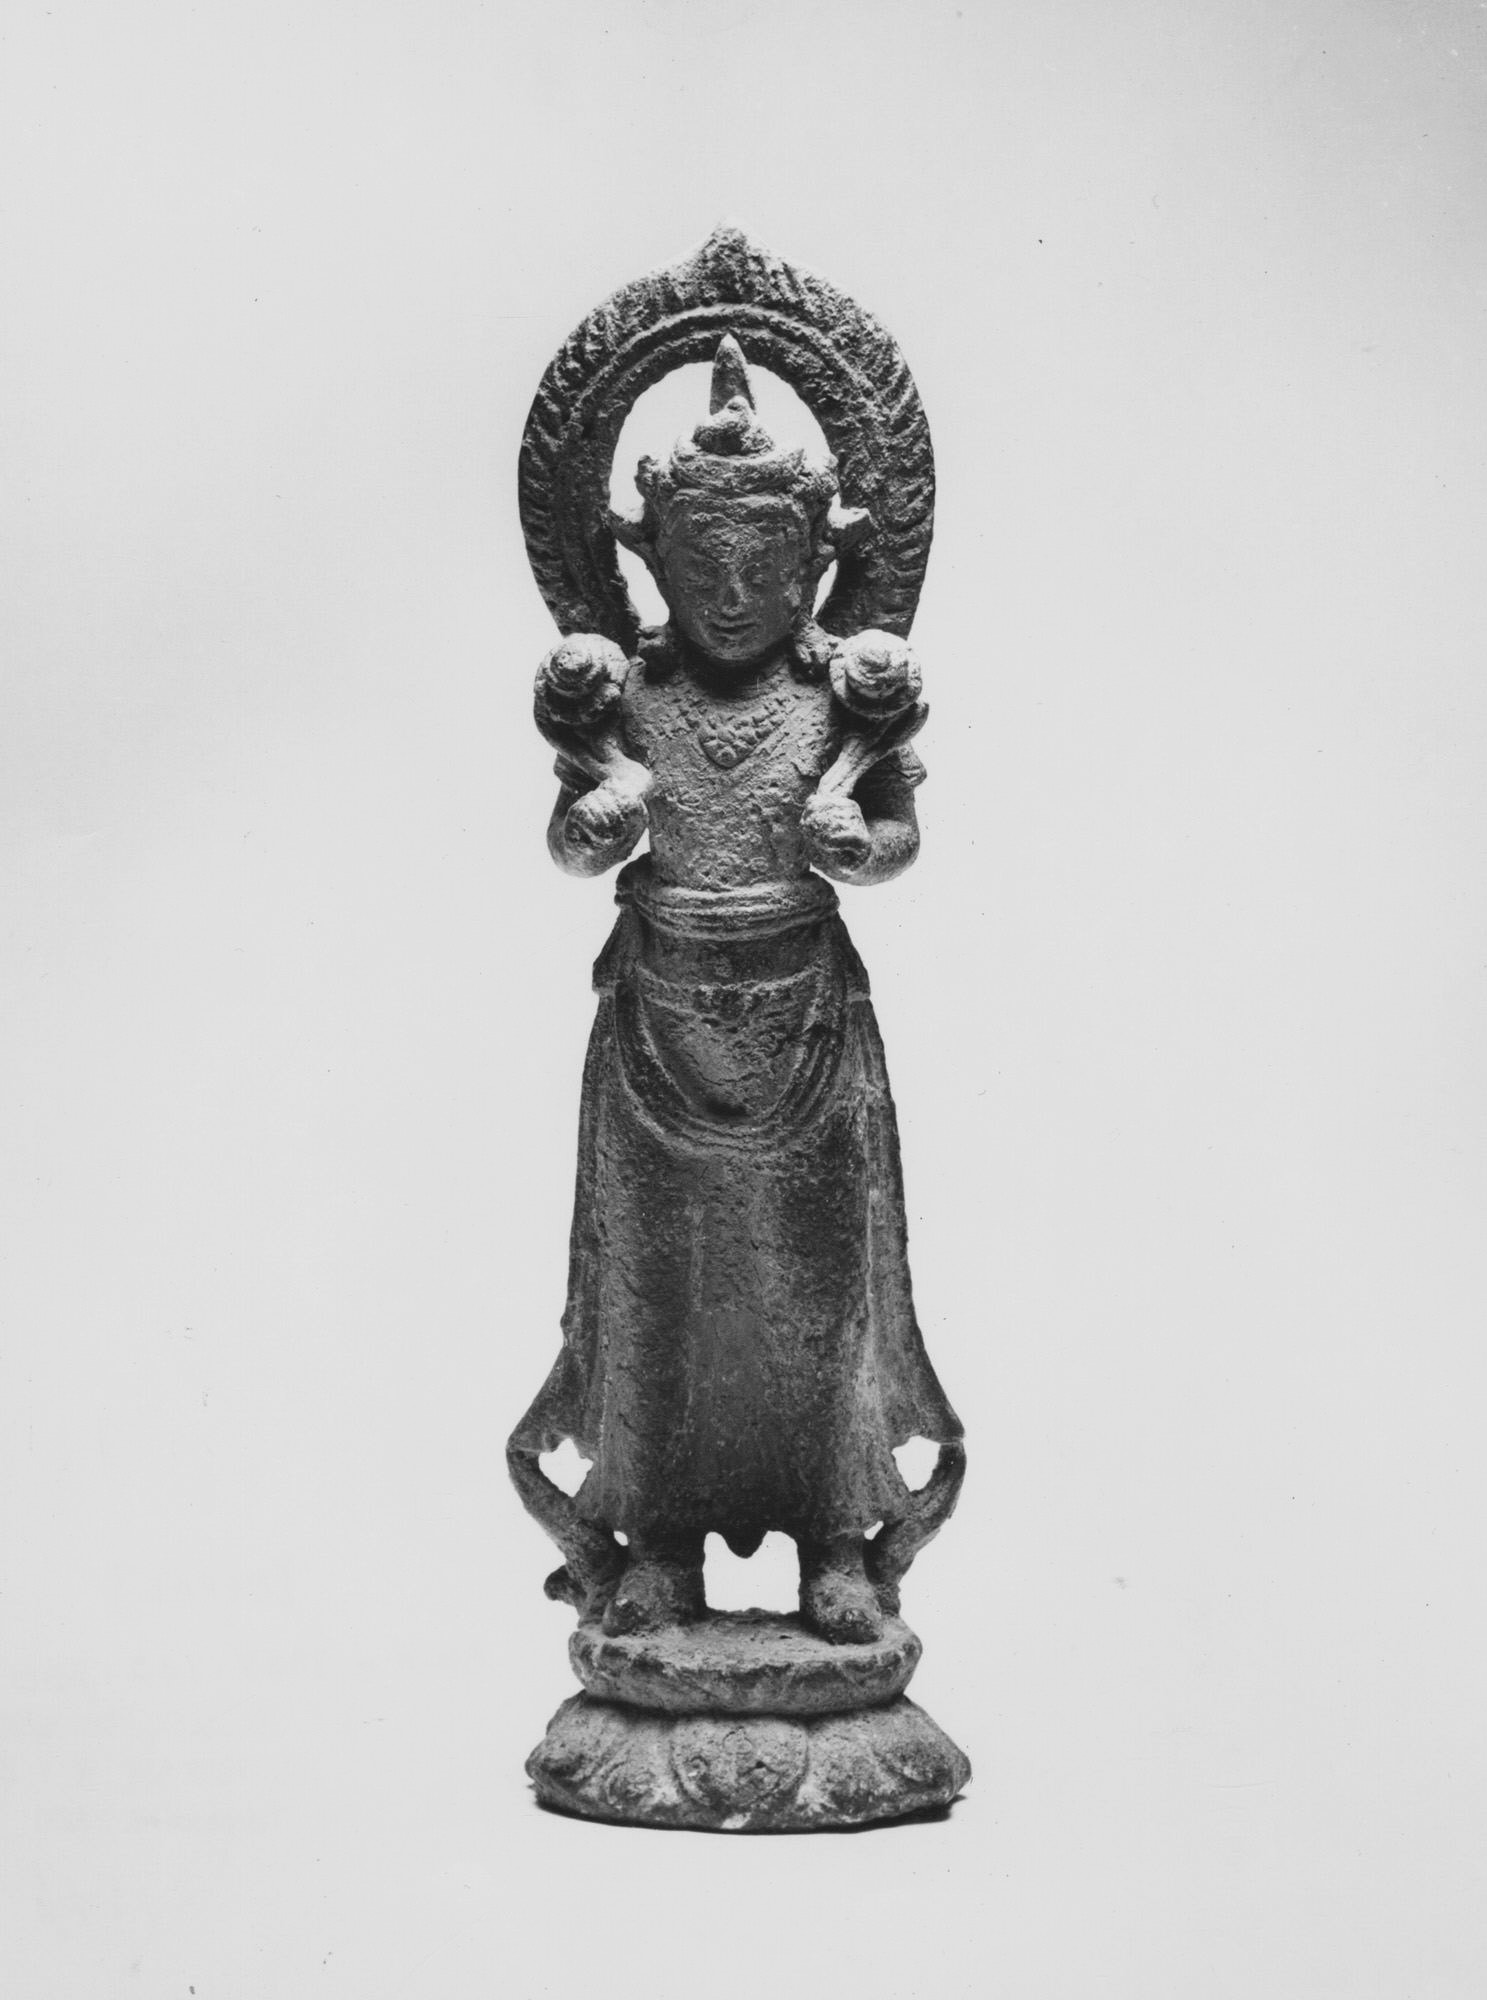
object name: figure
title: Standing Surya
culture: nepali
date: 1001-1200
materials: bronze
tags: gods,hinduism